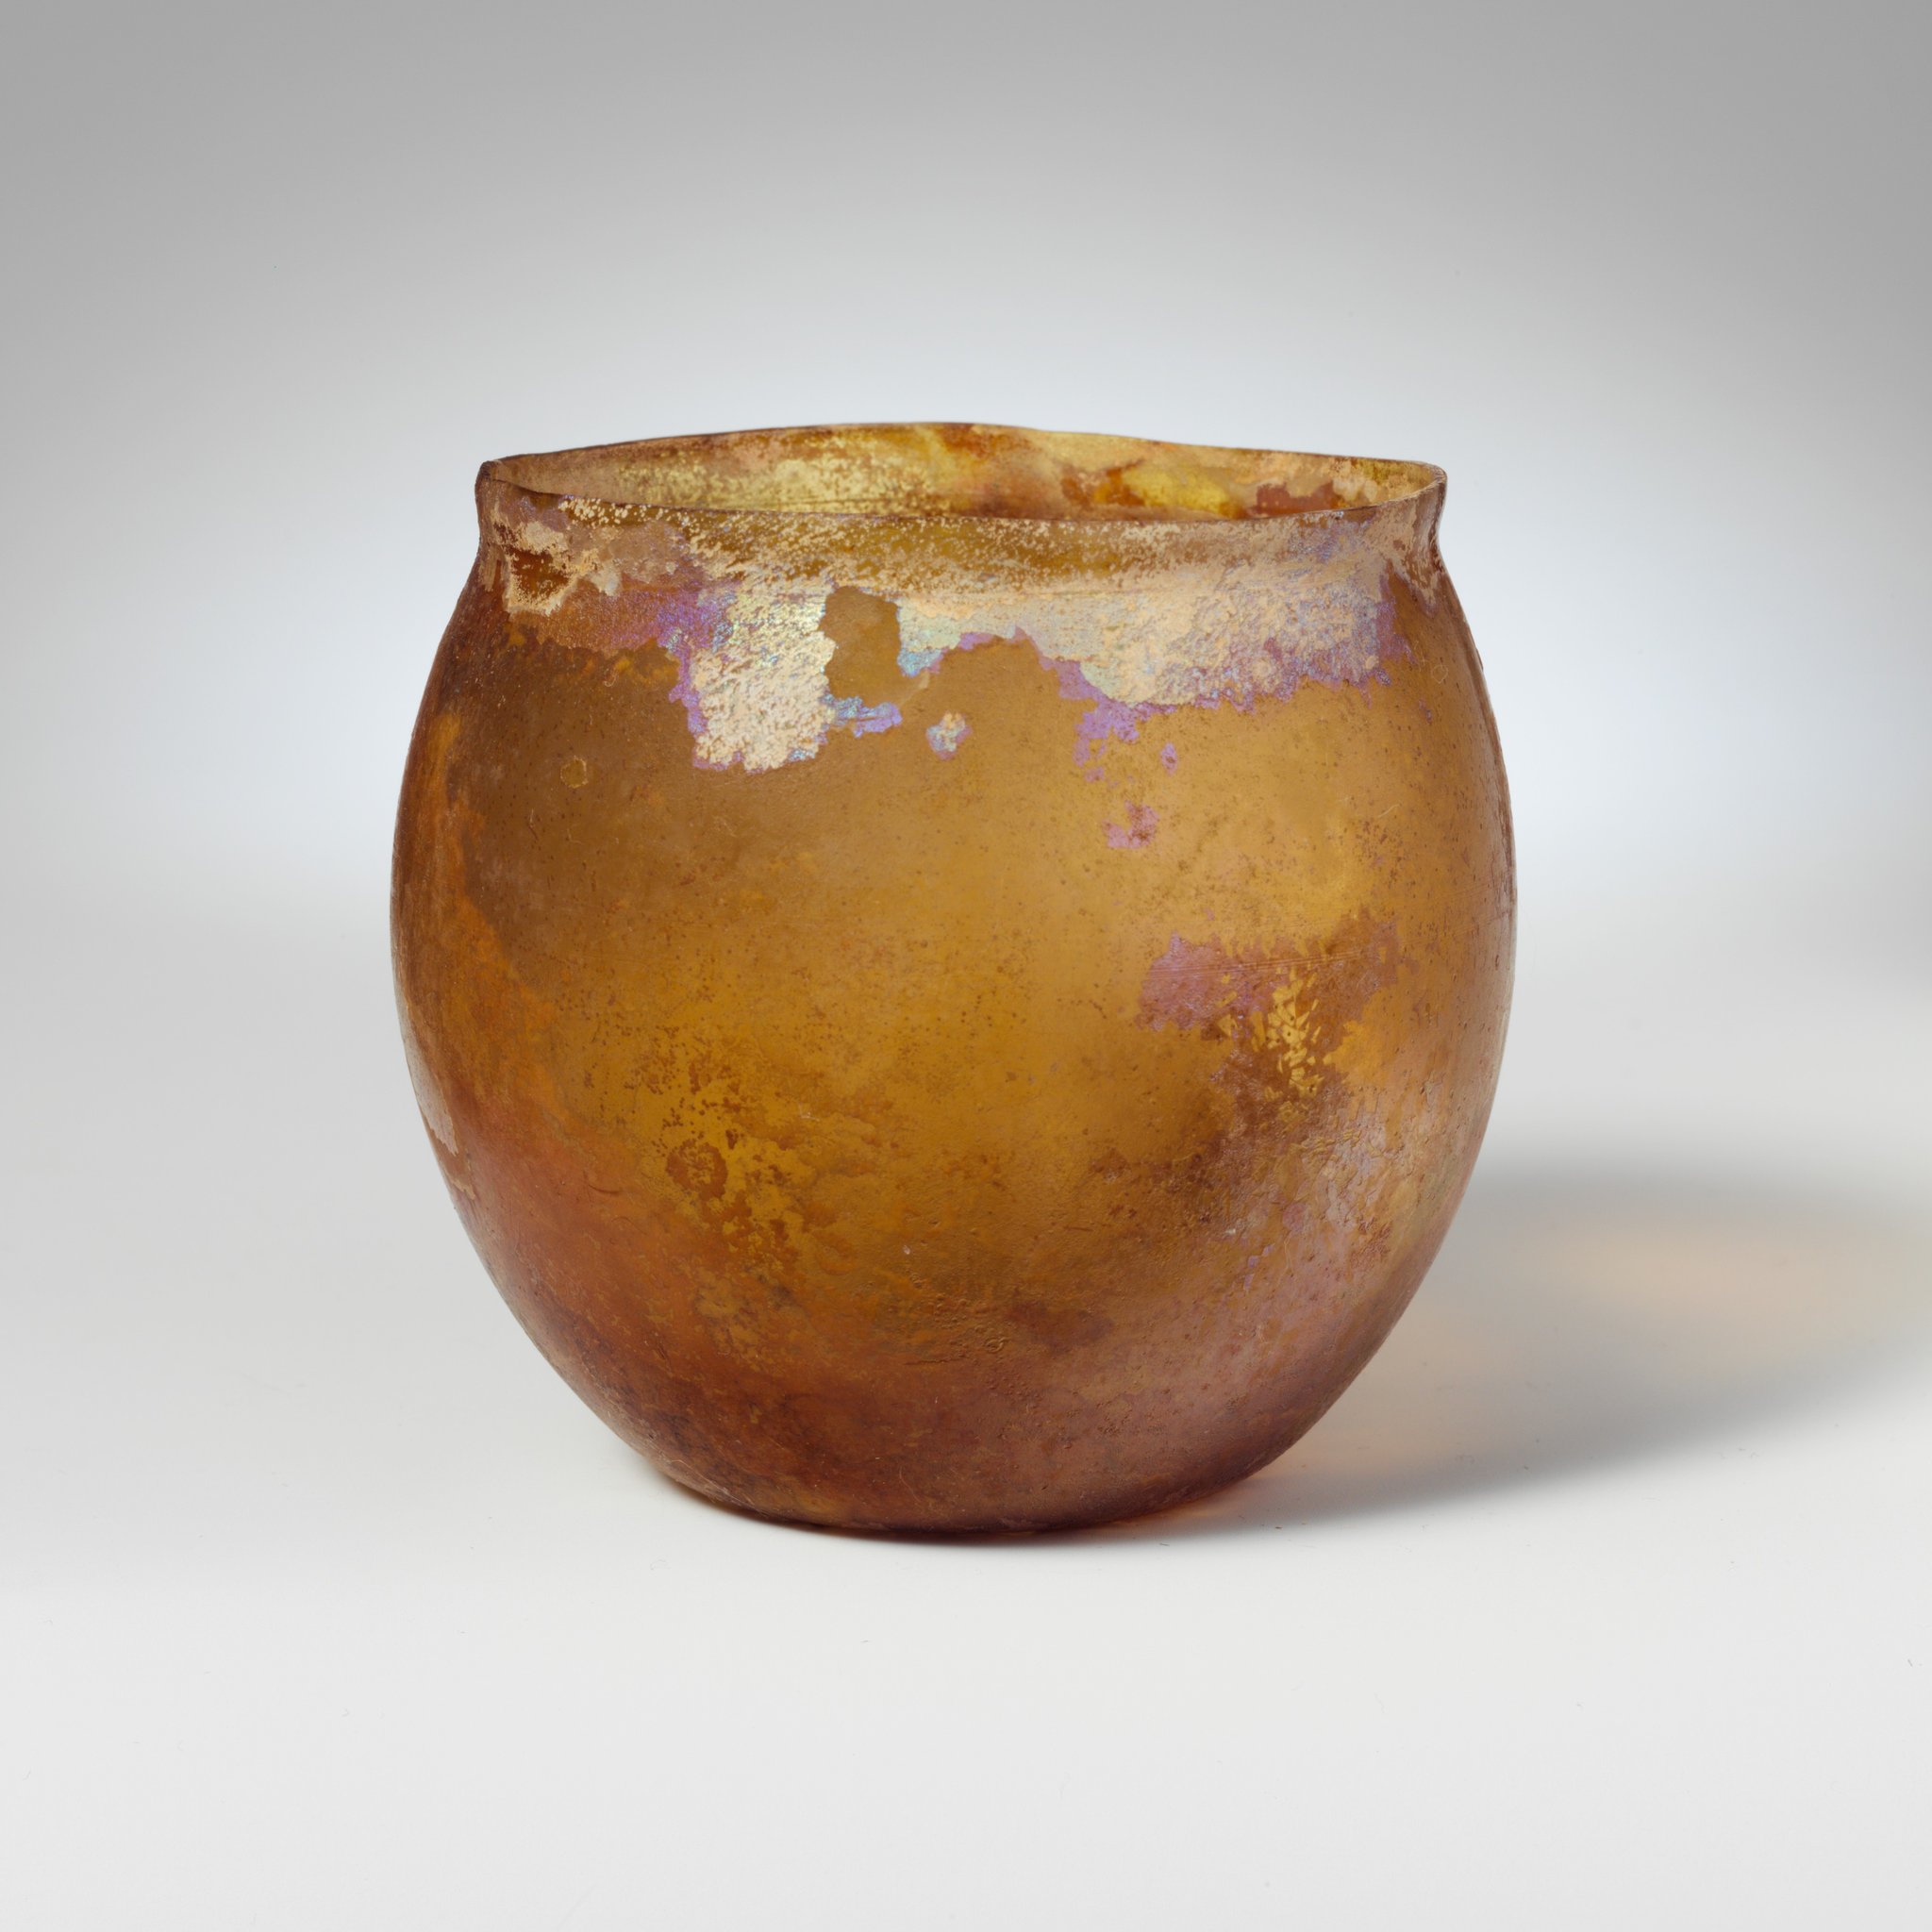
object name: cup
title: Glass cup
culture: roman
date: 1-100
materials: glass